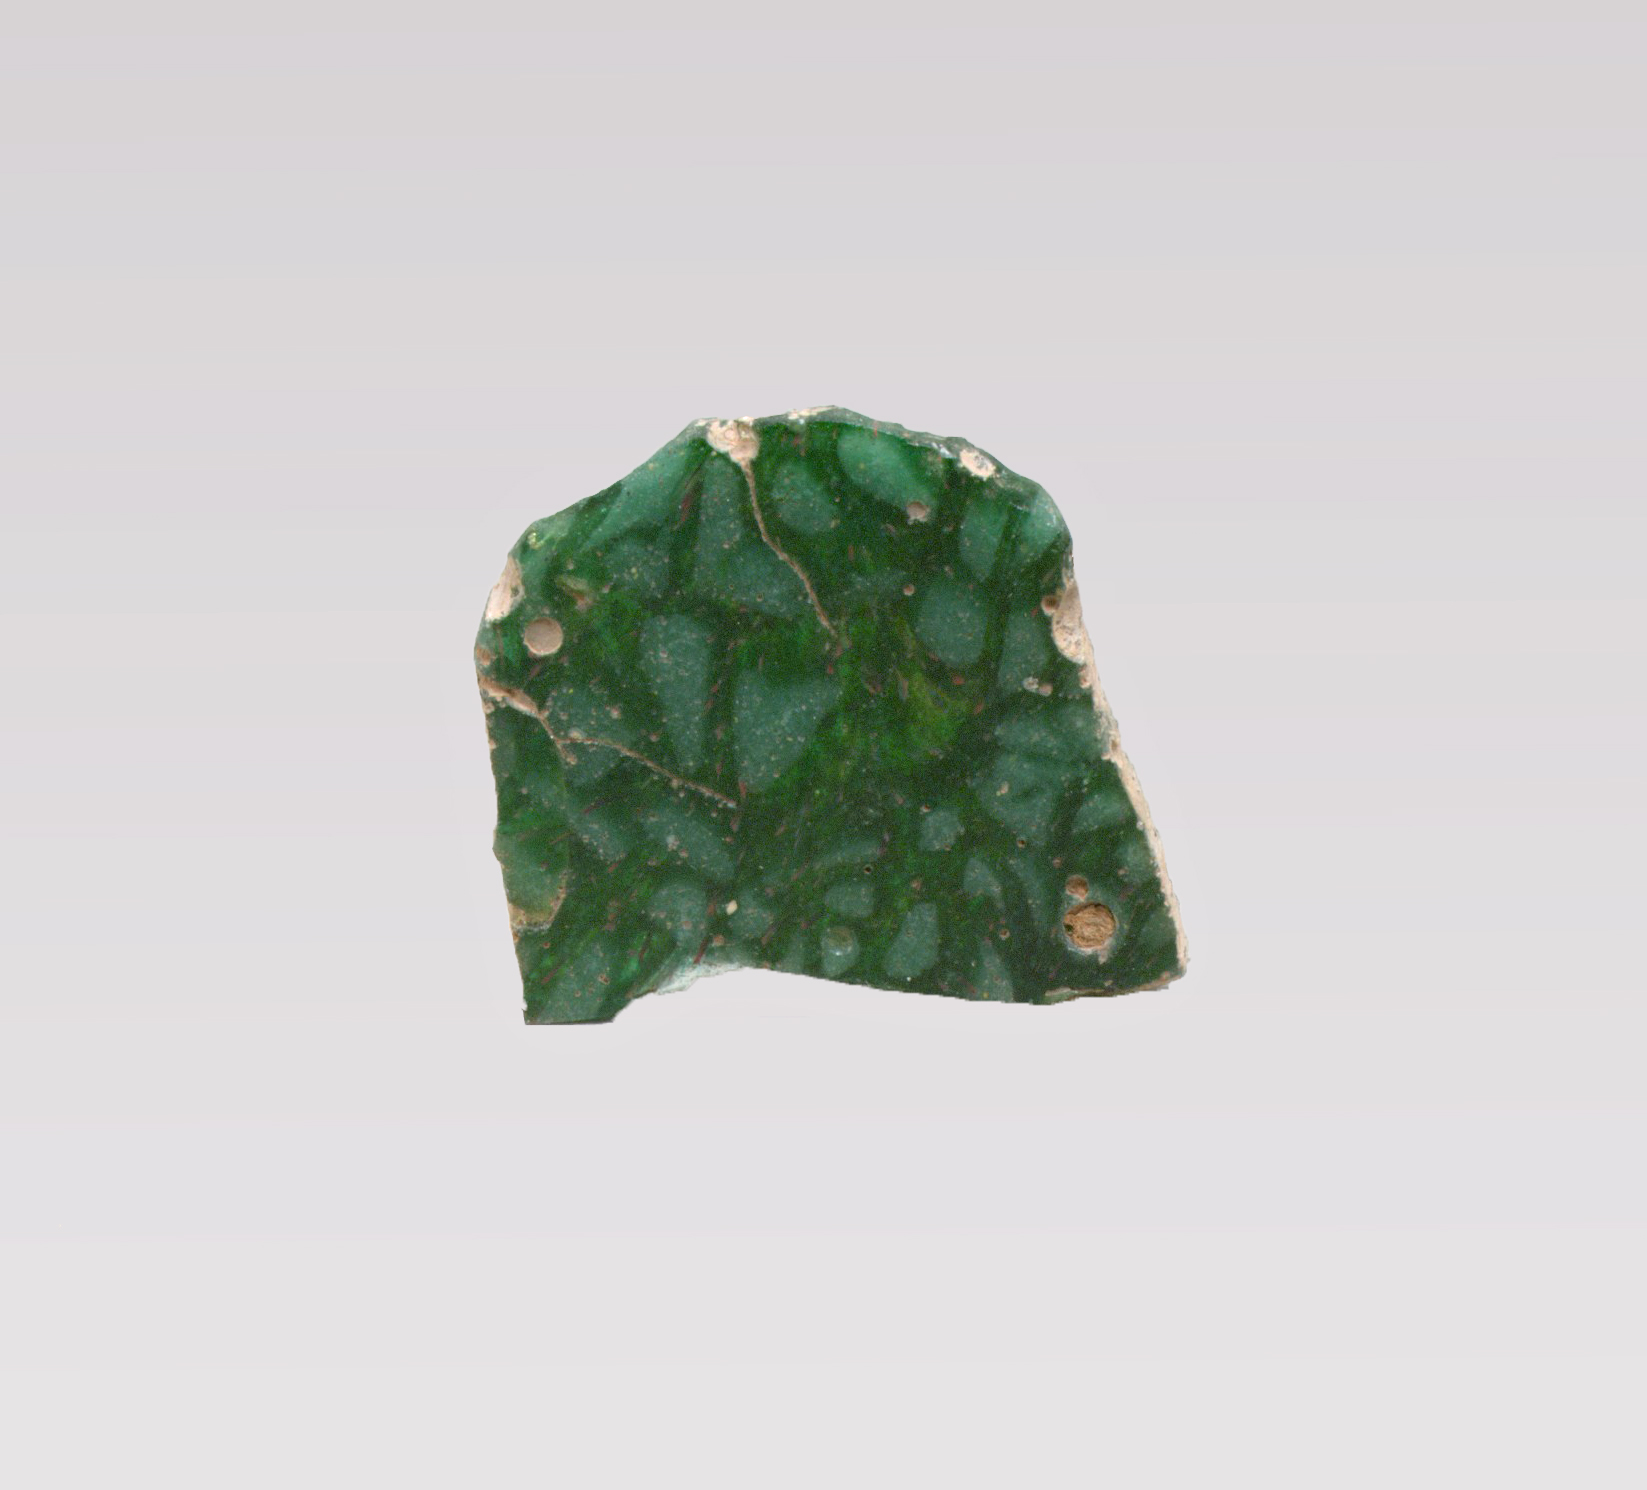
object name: fragment, mosaic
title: Glass mosaic inlay fragment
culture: roman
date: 34 BCE-33 CE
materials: glass